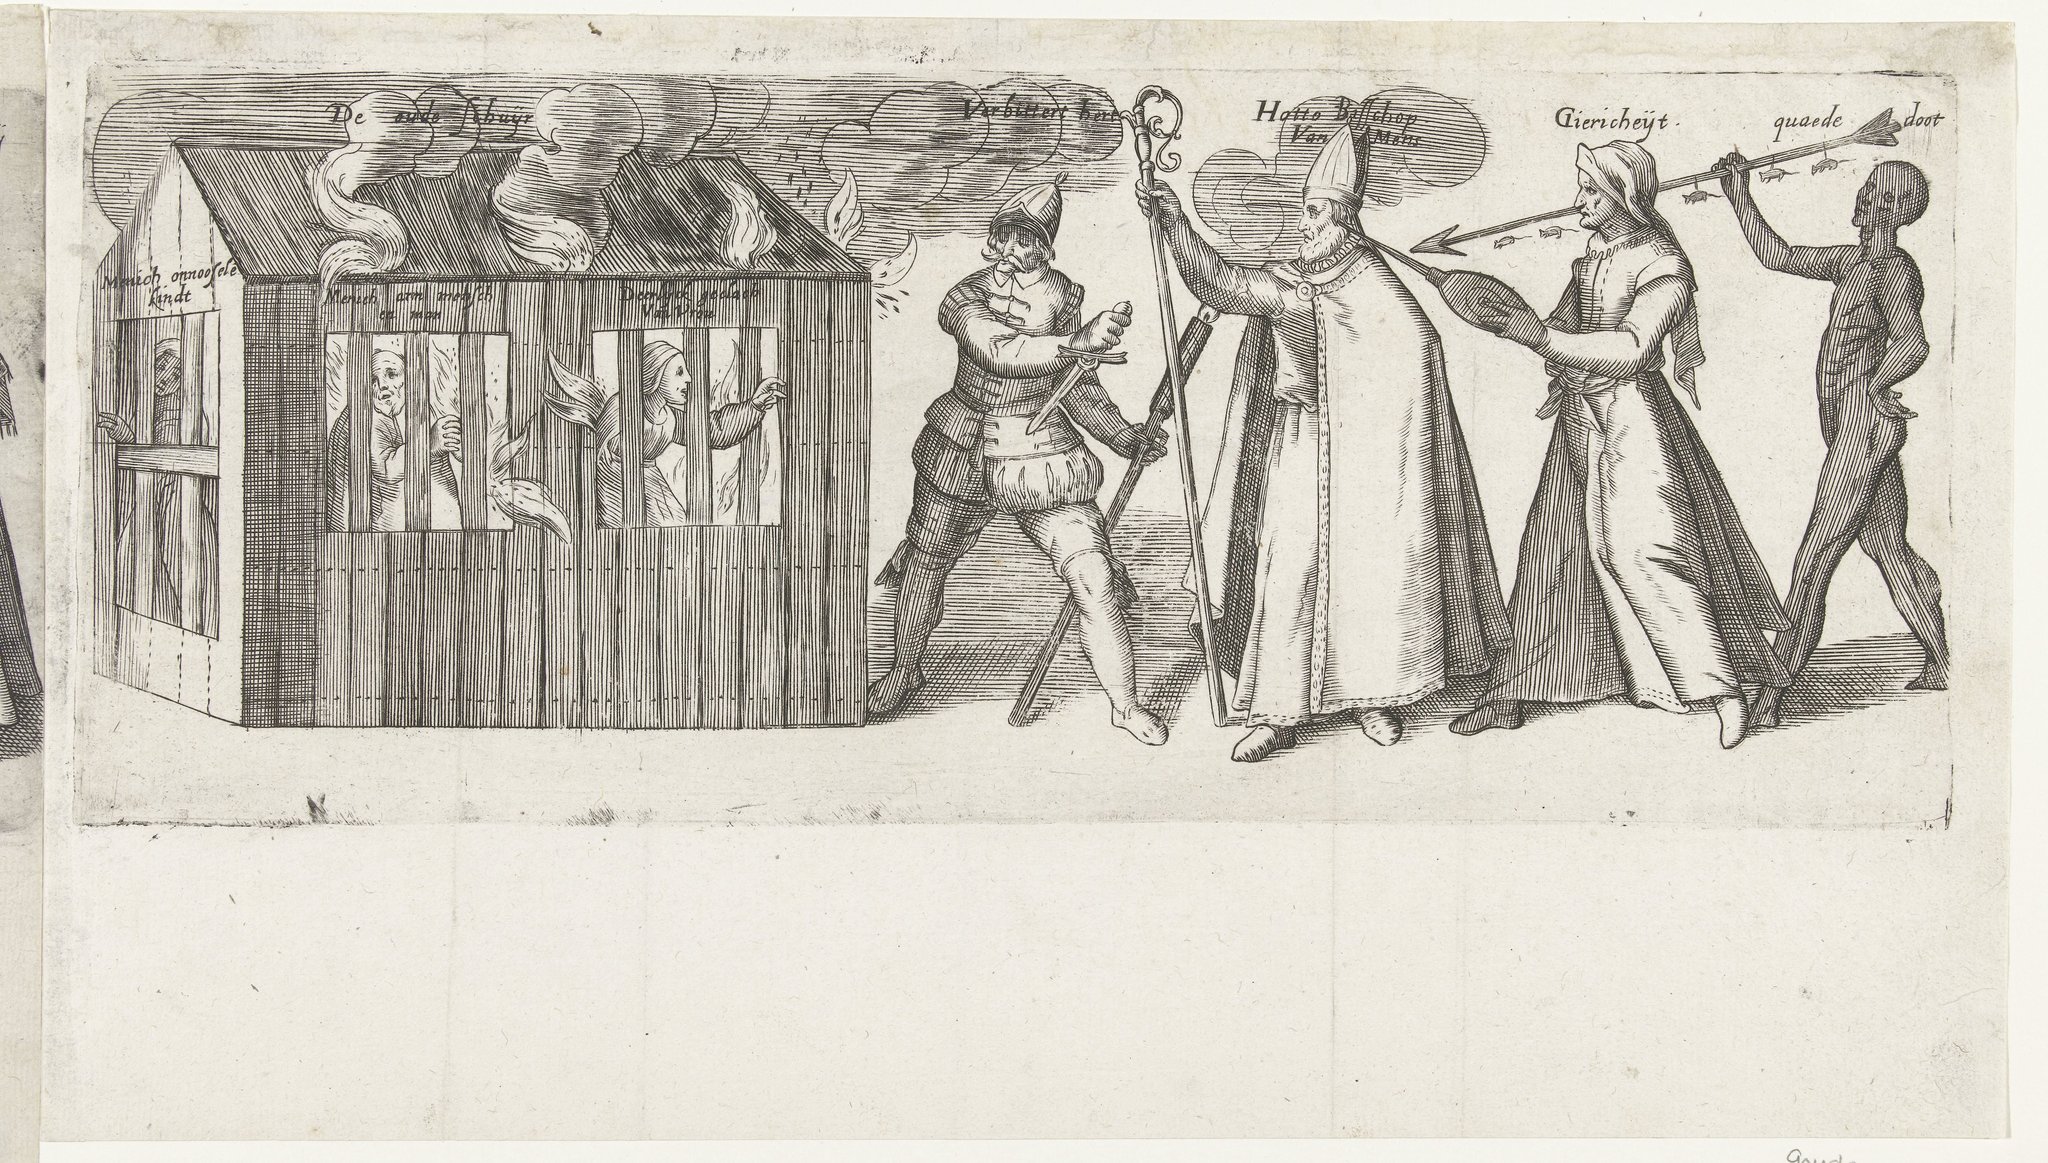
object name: print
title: Optocht door de rederijkerskamer De Goudsbloem uit Gouda (derde deel), 1607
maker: Anonymous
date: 1607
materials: paper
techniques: engraving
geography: northern netherlands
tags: chamber of rhetoric (dutch: 'rederijkerskamer'), festivities (+ parade, pageant, cavalcade ~ festive activities), haarlem, gouda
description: Gebruikt als illustratie in: Const-thoonende ivweel, by de loflijcke stadt Haerlem, ten versoecke van Trou moet blijcken, in't licht gebracht. : Waer inne duydelick verclaert ende verthoont wordt alles wat den mensche mach wecken om den armen te troosten, ende zijnen naesten by te staen. : In twaelf spelen van sinne ... in redenrijck naar de volgende voorgegevene caerte van 't speel-korenken, Zacharias Heyns, Zwolle 1607. Los fragment, bedoeld om samen met de andere delen tot een fries gemonteerd te worden.